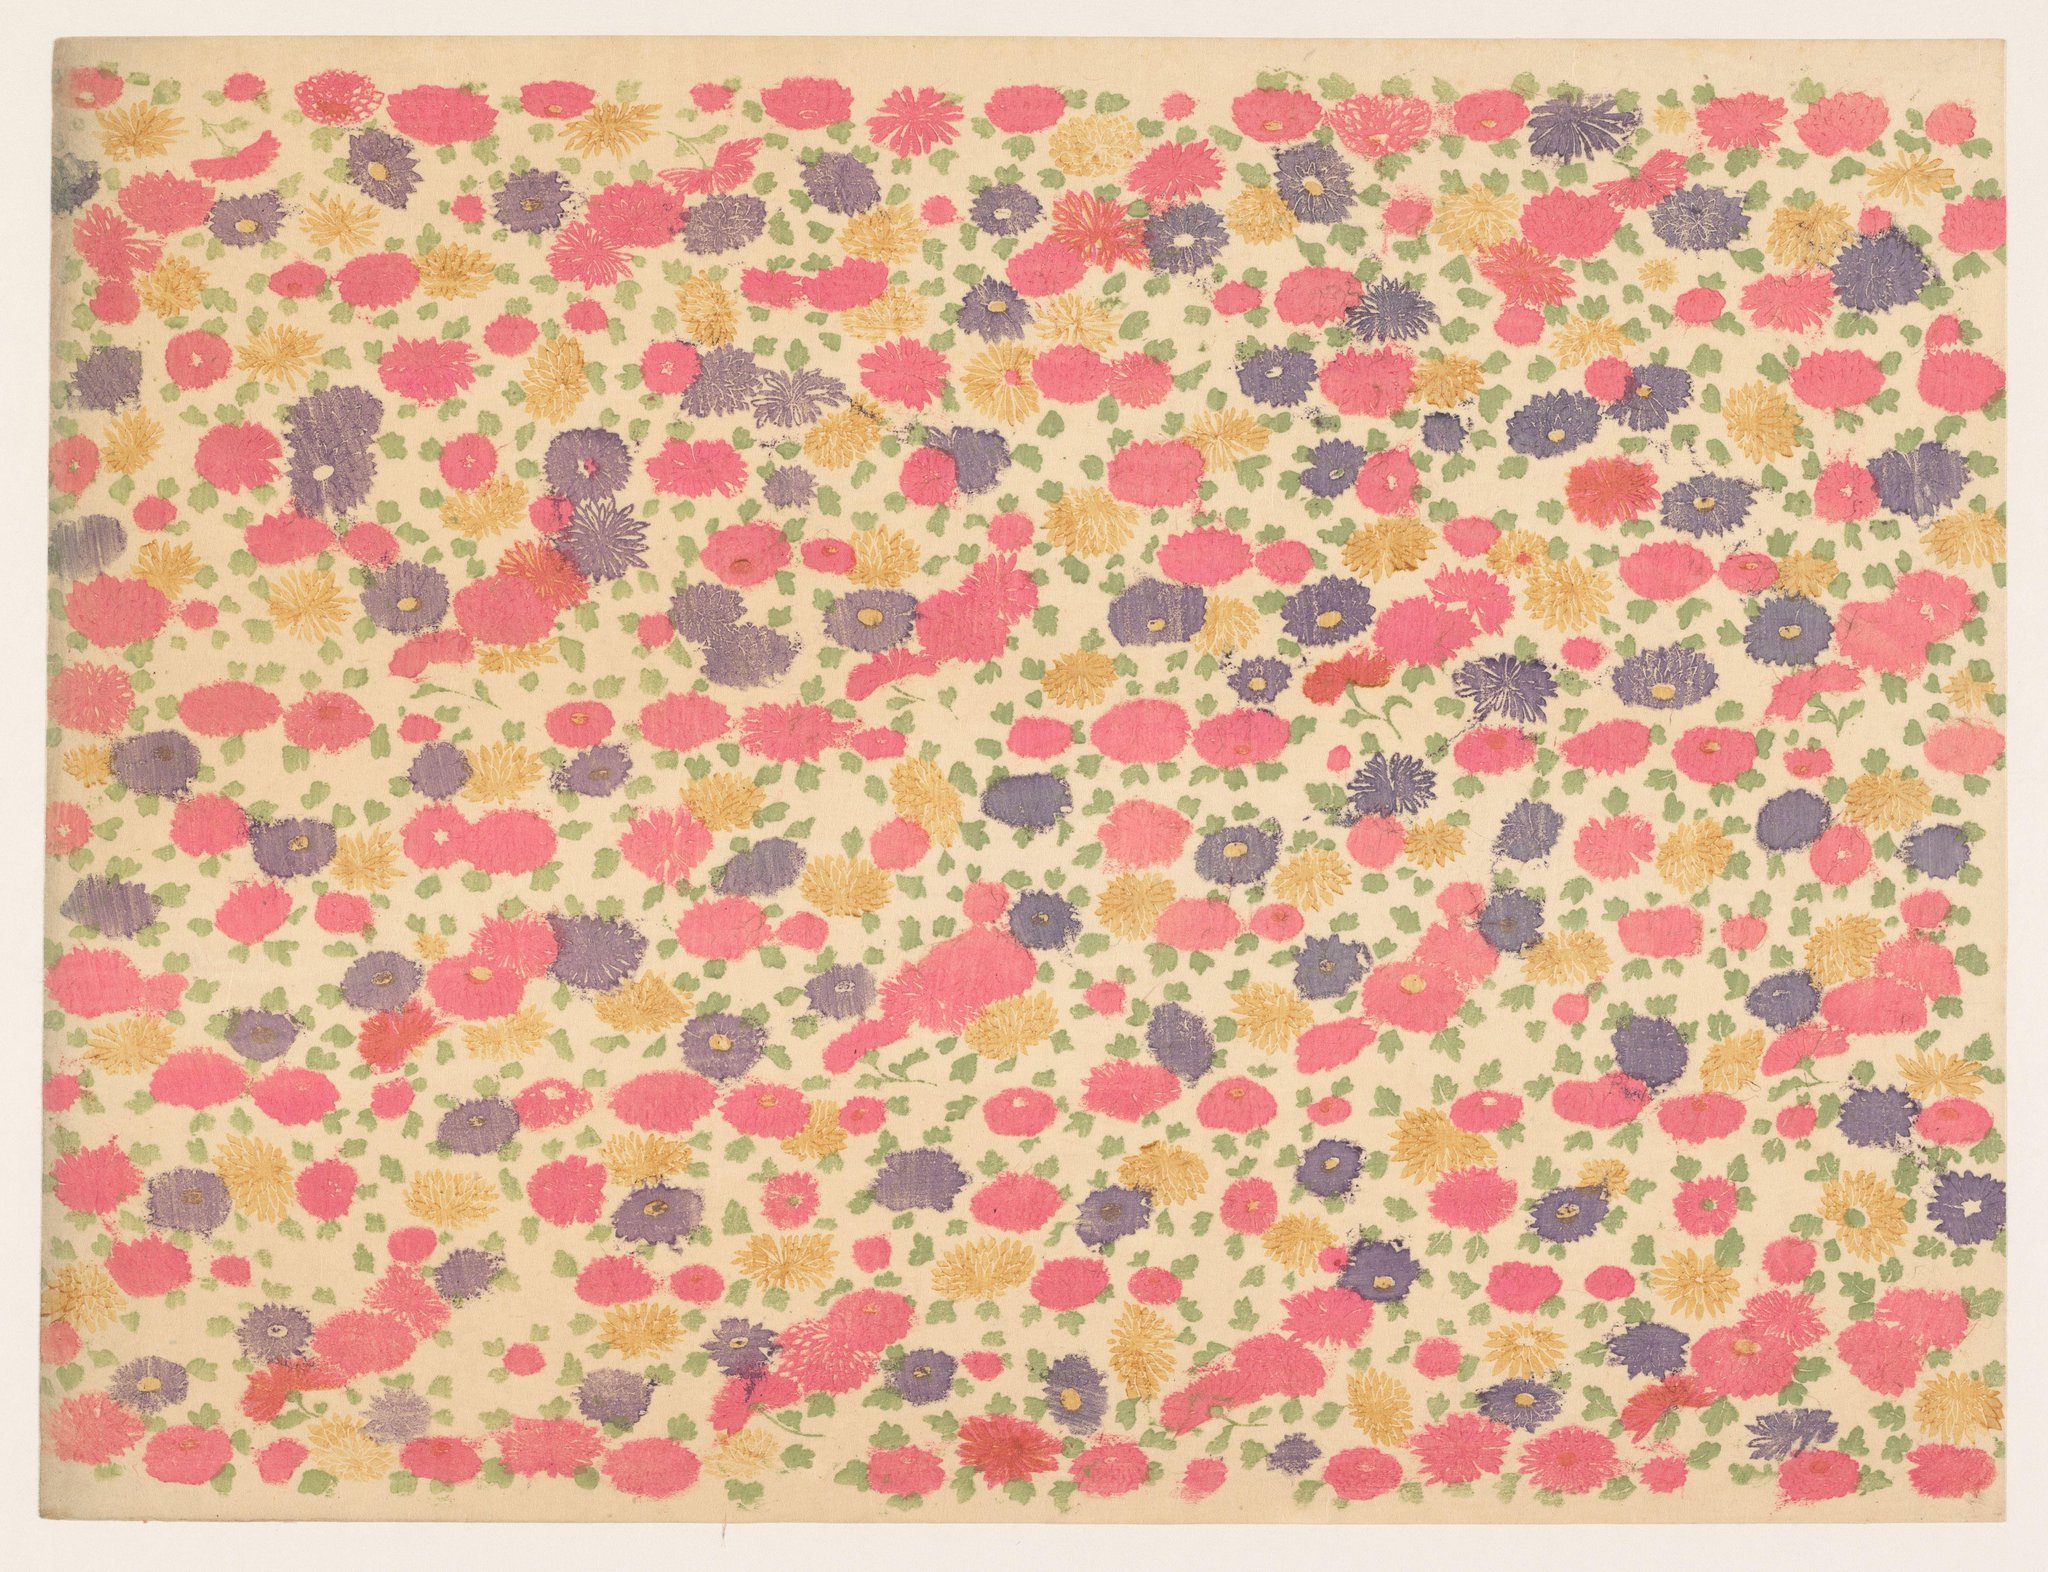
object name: decorated paper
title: Strooipatroon van bloemen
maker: Anonymous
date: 1860-1930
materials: paper, paint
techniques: printing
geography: japan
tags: ornament derived from plant forms